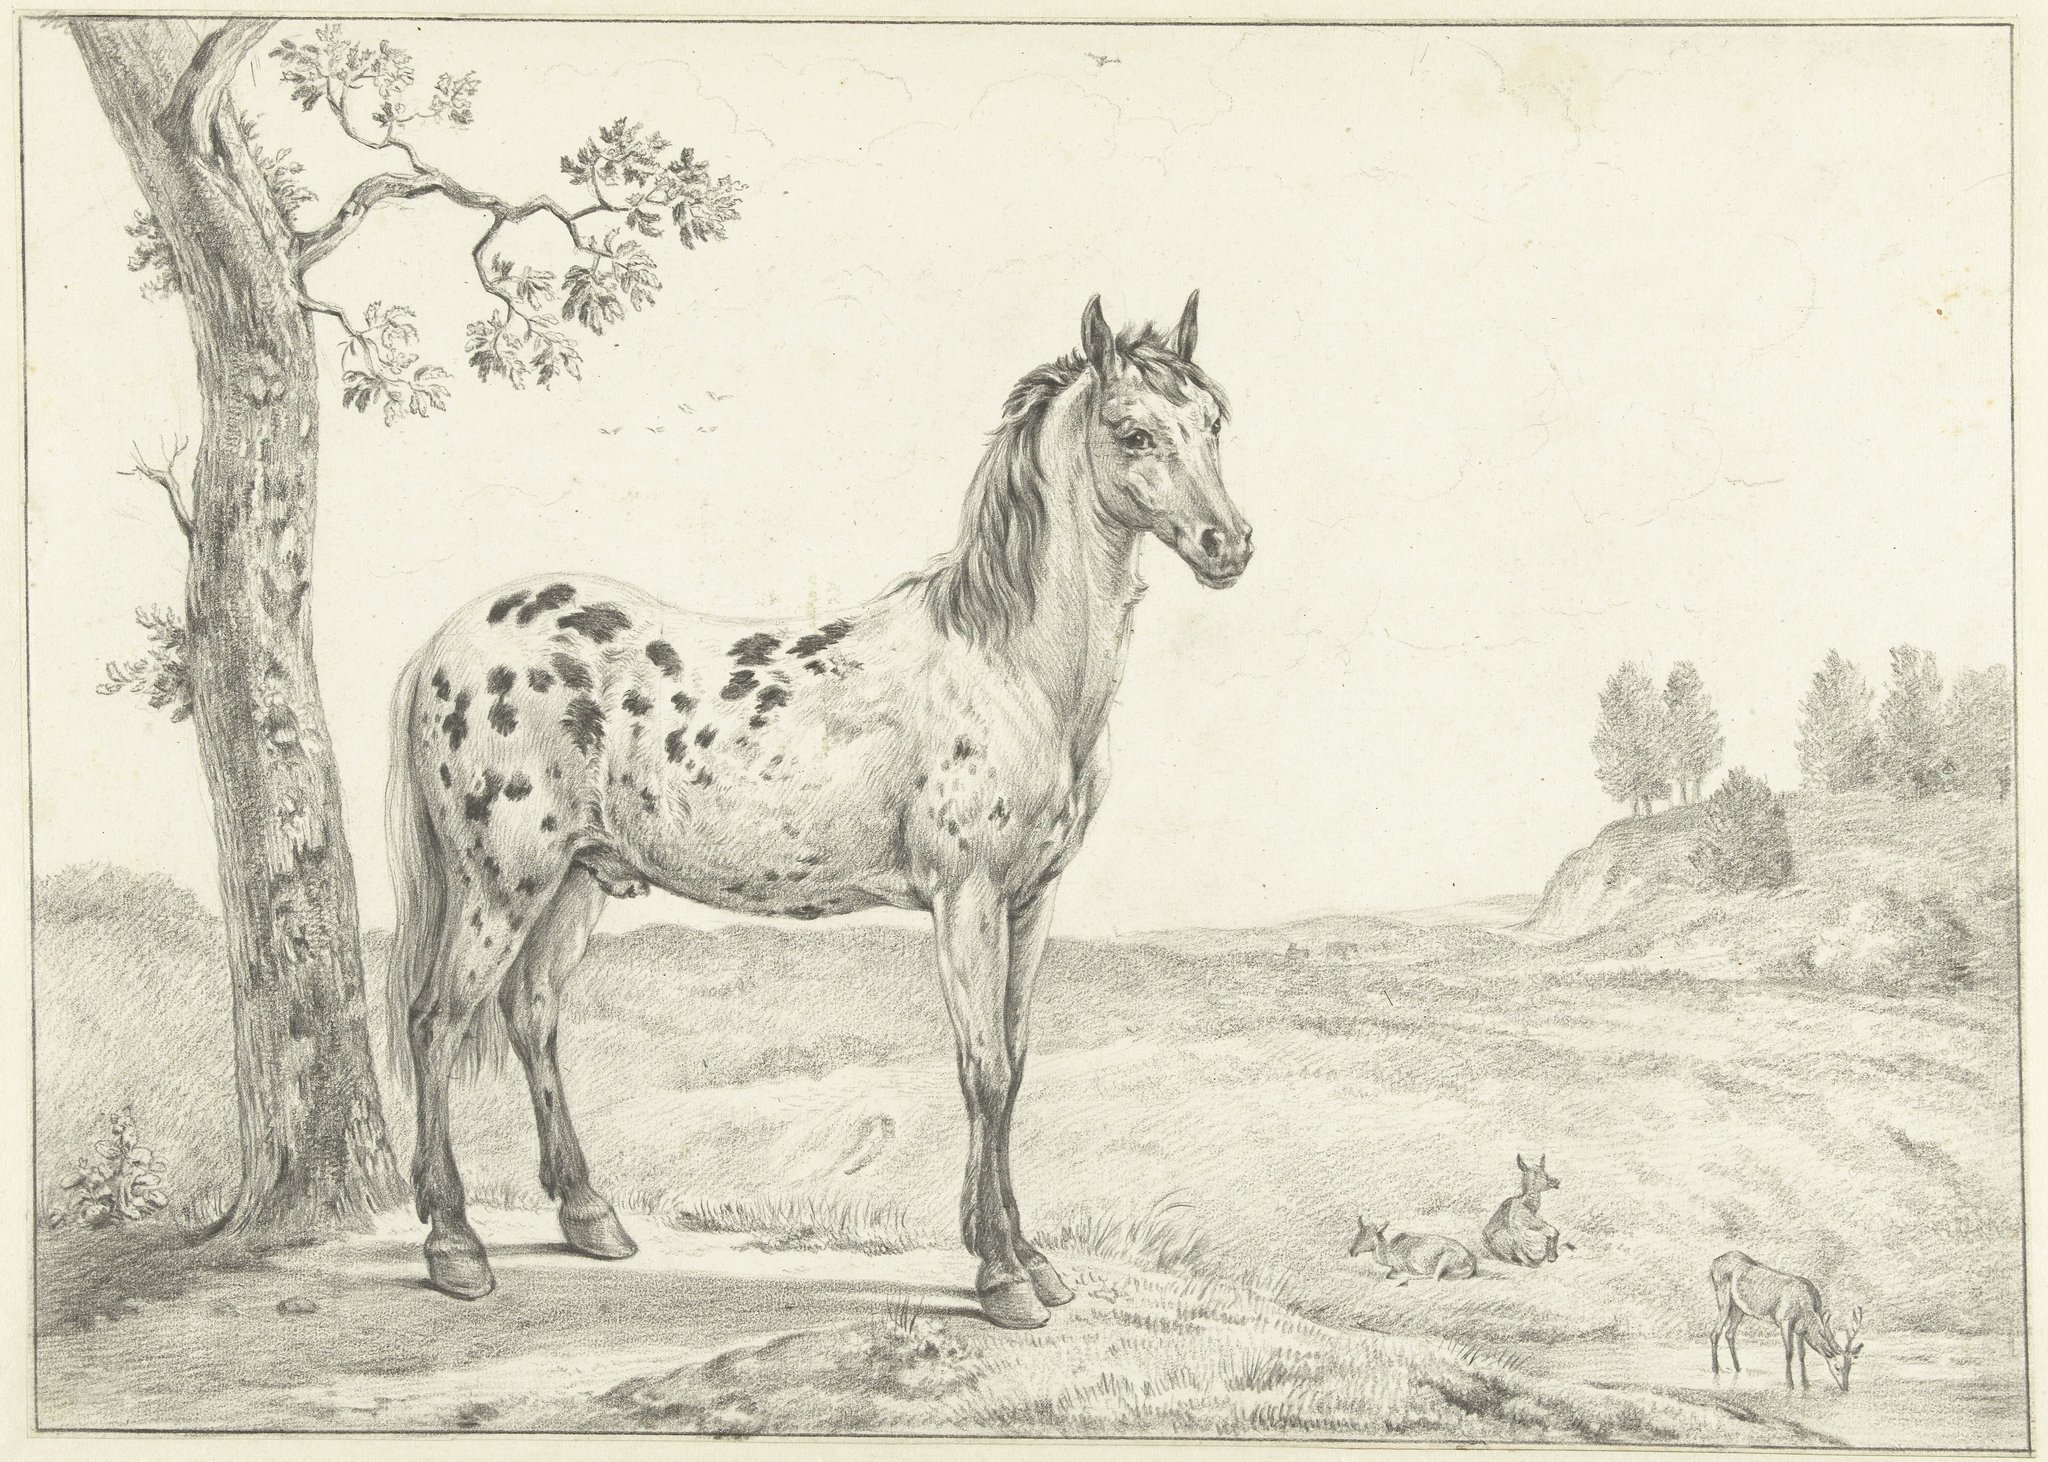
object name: drawing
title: Staand gevlekt paard, naar rechts, in een landschap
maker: jean bernard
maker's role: draughtsman, print maker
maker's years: 1765-1833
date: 1775-1833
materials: chalk, paper, pencil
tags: horse